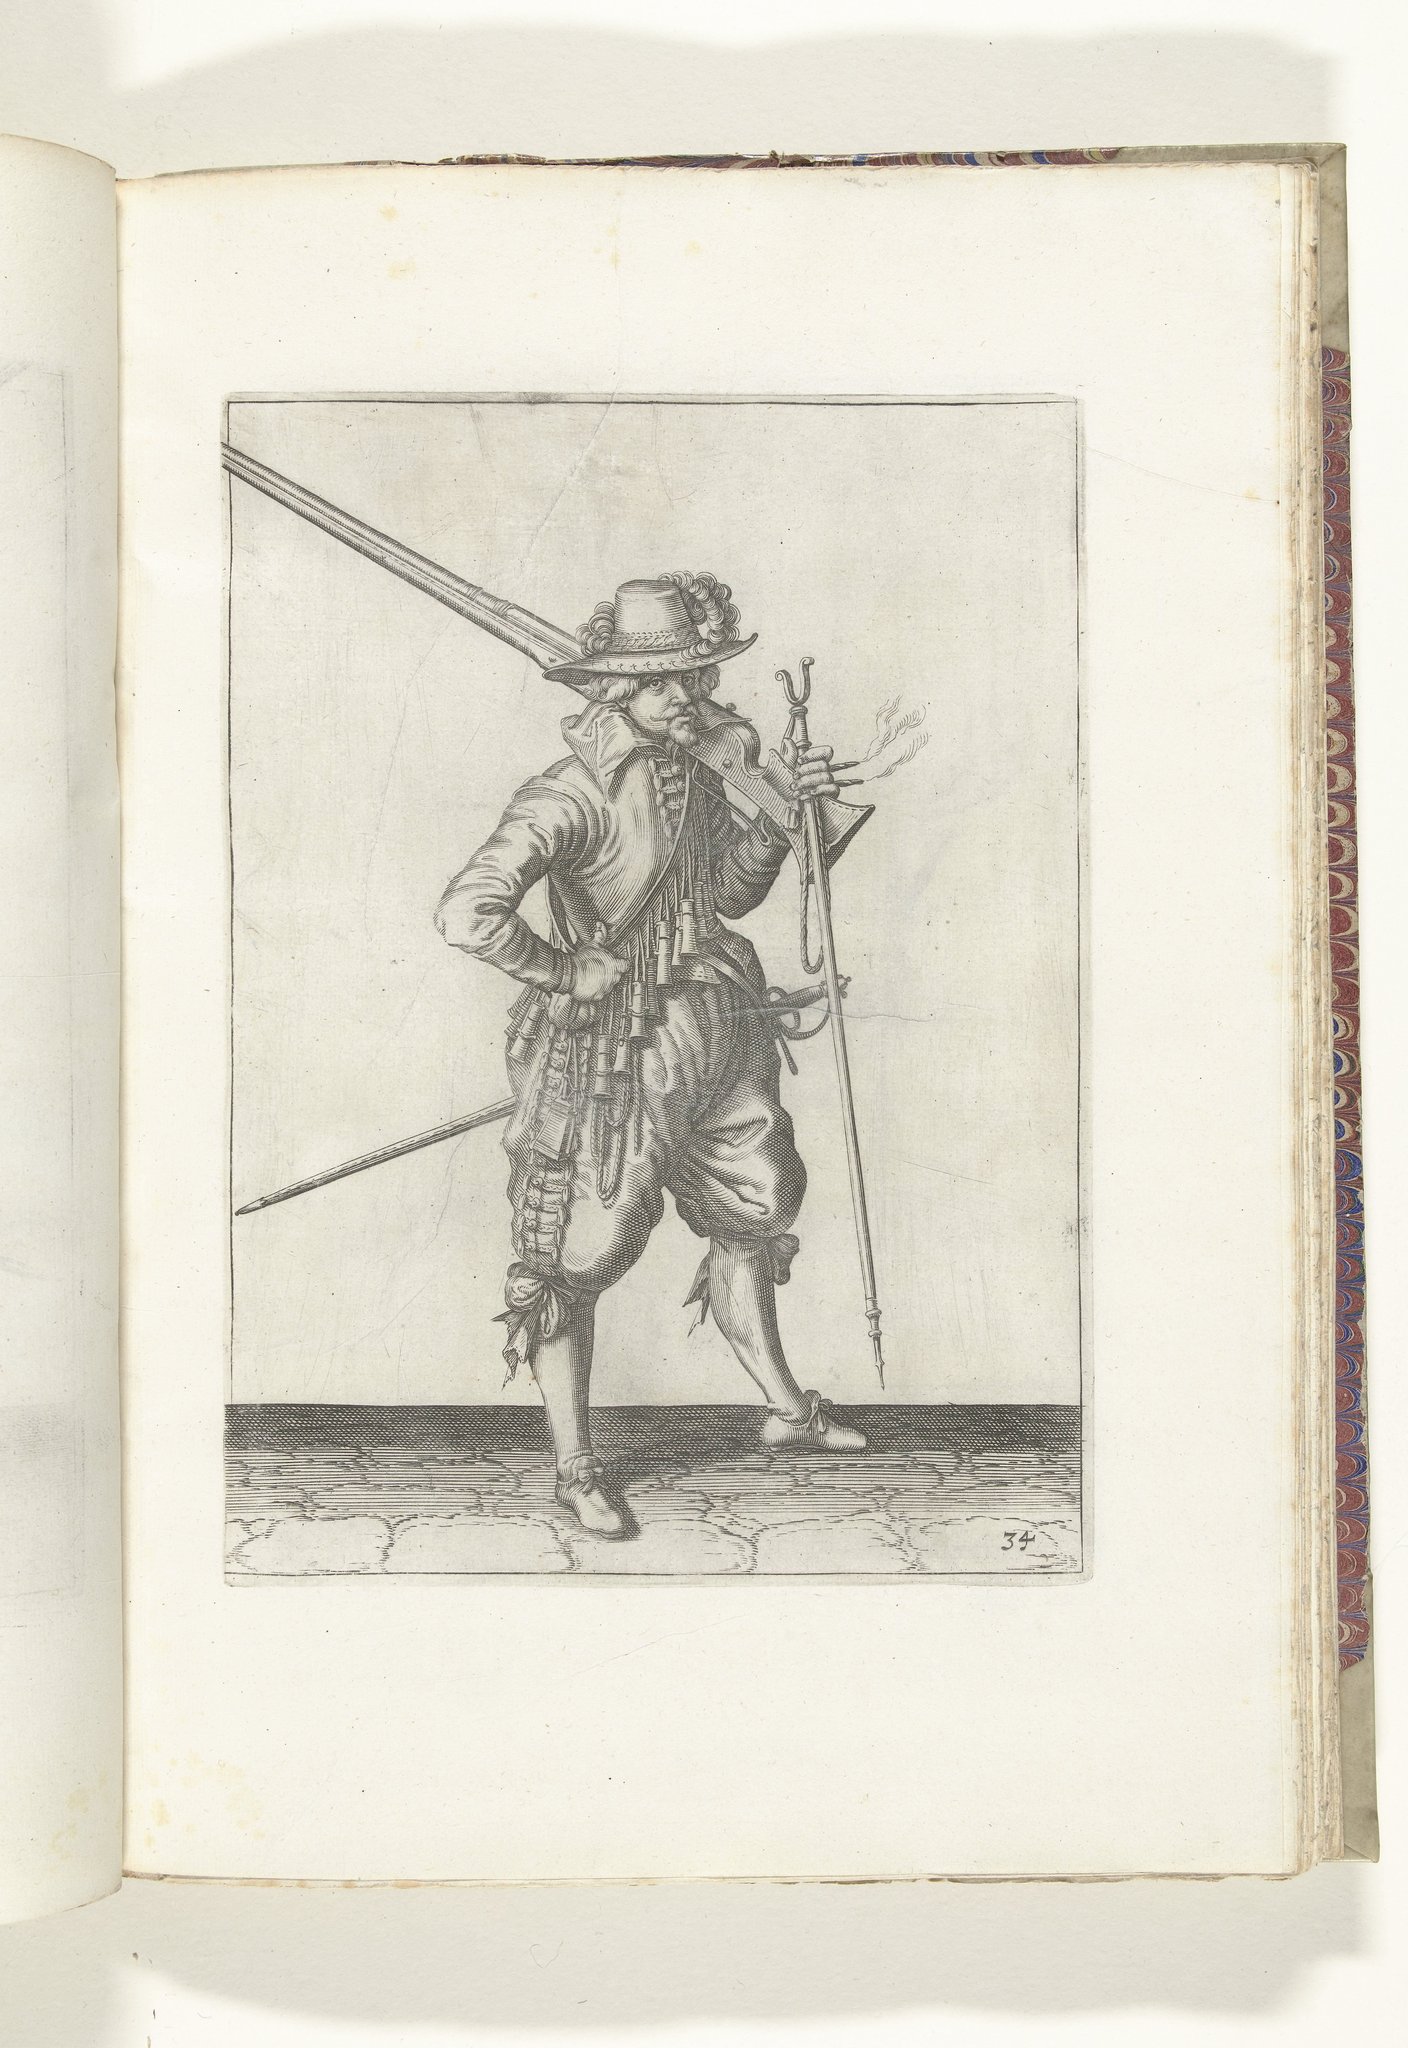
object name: print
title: Soldaat die zijn musket op zijn schouder draagt (nr. 34), ca. 1600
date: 1597-1607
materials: paper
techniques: engraving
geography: northern netherlands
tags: the hague, maurice (prince of orange), handling of weapons ~ military training, weapons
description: Een soldaat, ten voeten uit, naar rechts, met een musket (een bepaald type vuurwapen) steunend op zijn linkerschouder (nr. 34), ca. 1600. In zijn linkerhand behalve de kolf van het musket ook een brandende lont en een furket (musketvork). Het gaat dus om (vrijwel) dezelfde positie als degene die op de tweede prent van de serie getoond wordt. Rechtsonder de foutieve nummering 2 gewist en opnieuw genummerd 34. Plaat 34 in de instructies voor het hanteren van het musket: Corte onderrechtinghe op de figuerlicke afbeeldinghe, soo veel aengaet het recht ghebruyck van Musquet. Onderdeel van de illustraties in: J. de Gheyn, Wapenhandelinghe van Roers Musquetten ende spiessen, Amsterdam, 1608. Krijgswezen rond 1600.